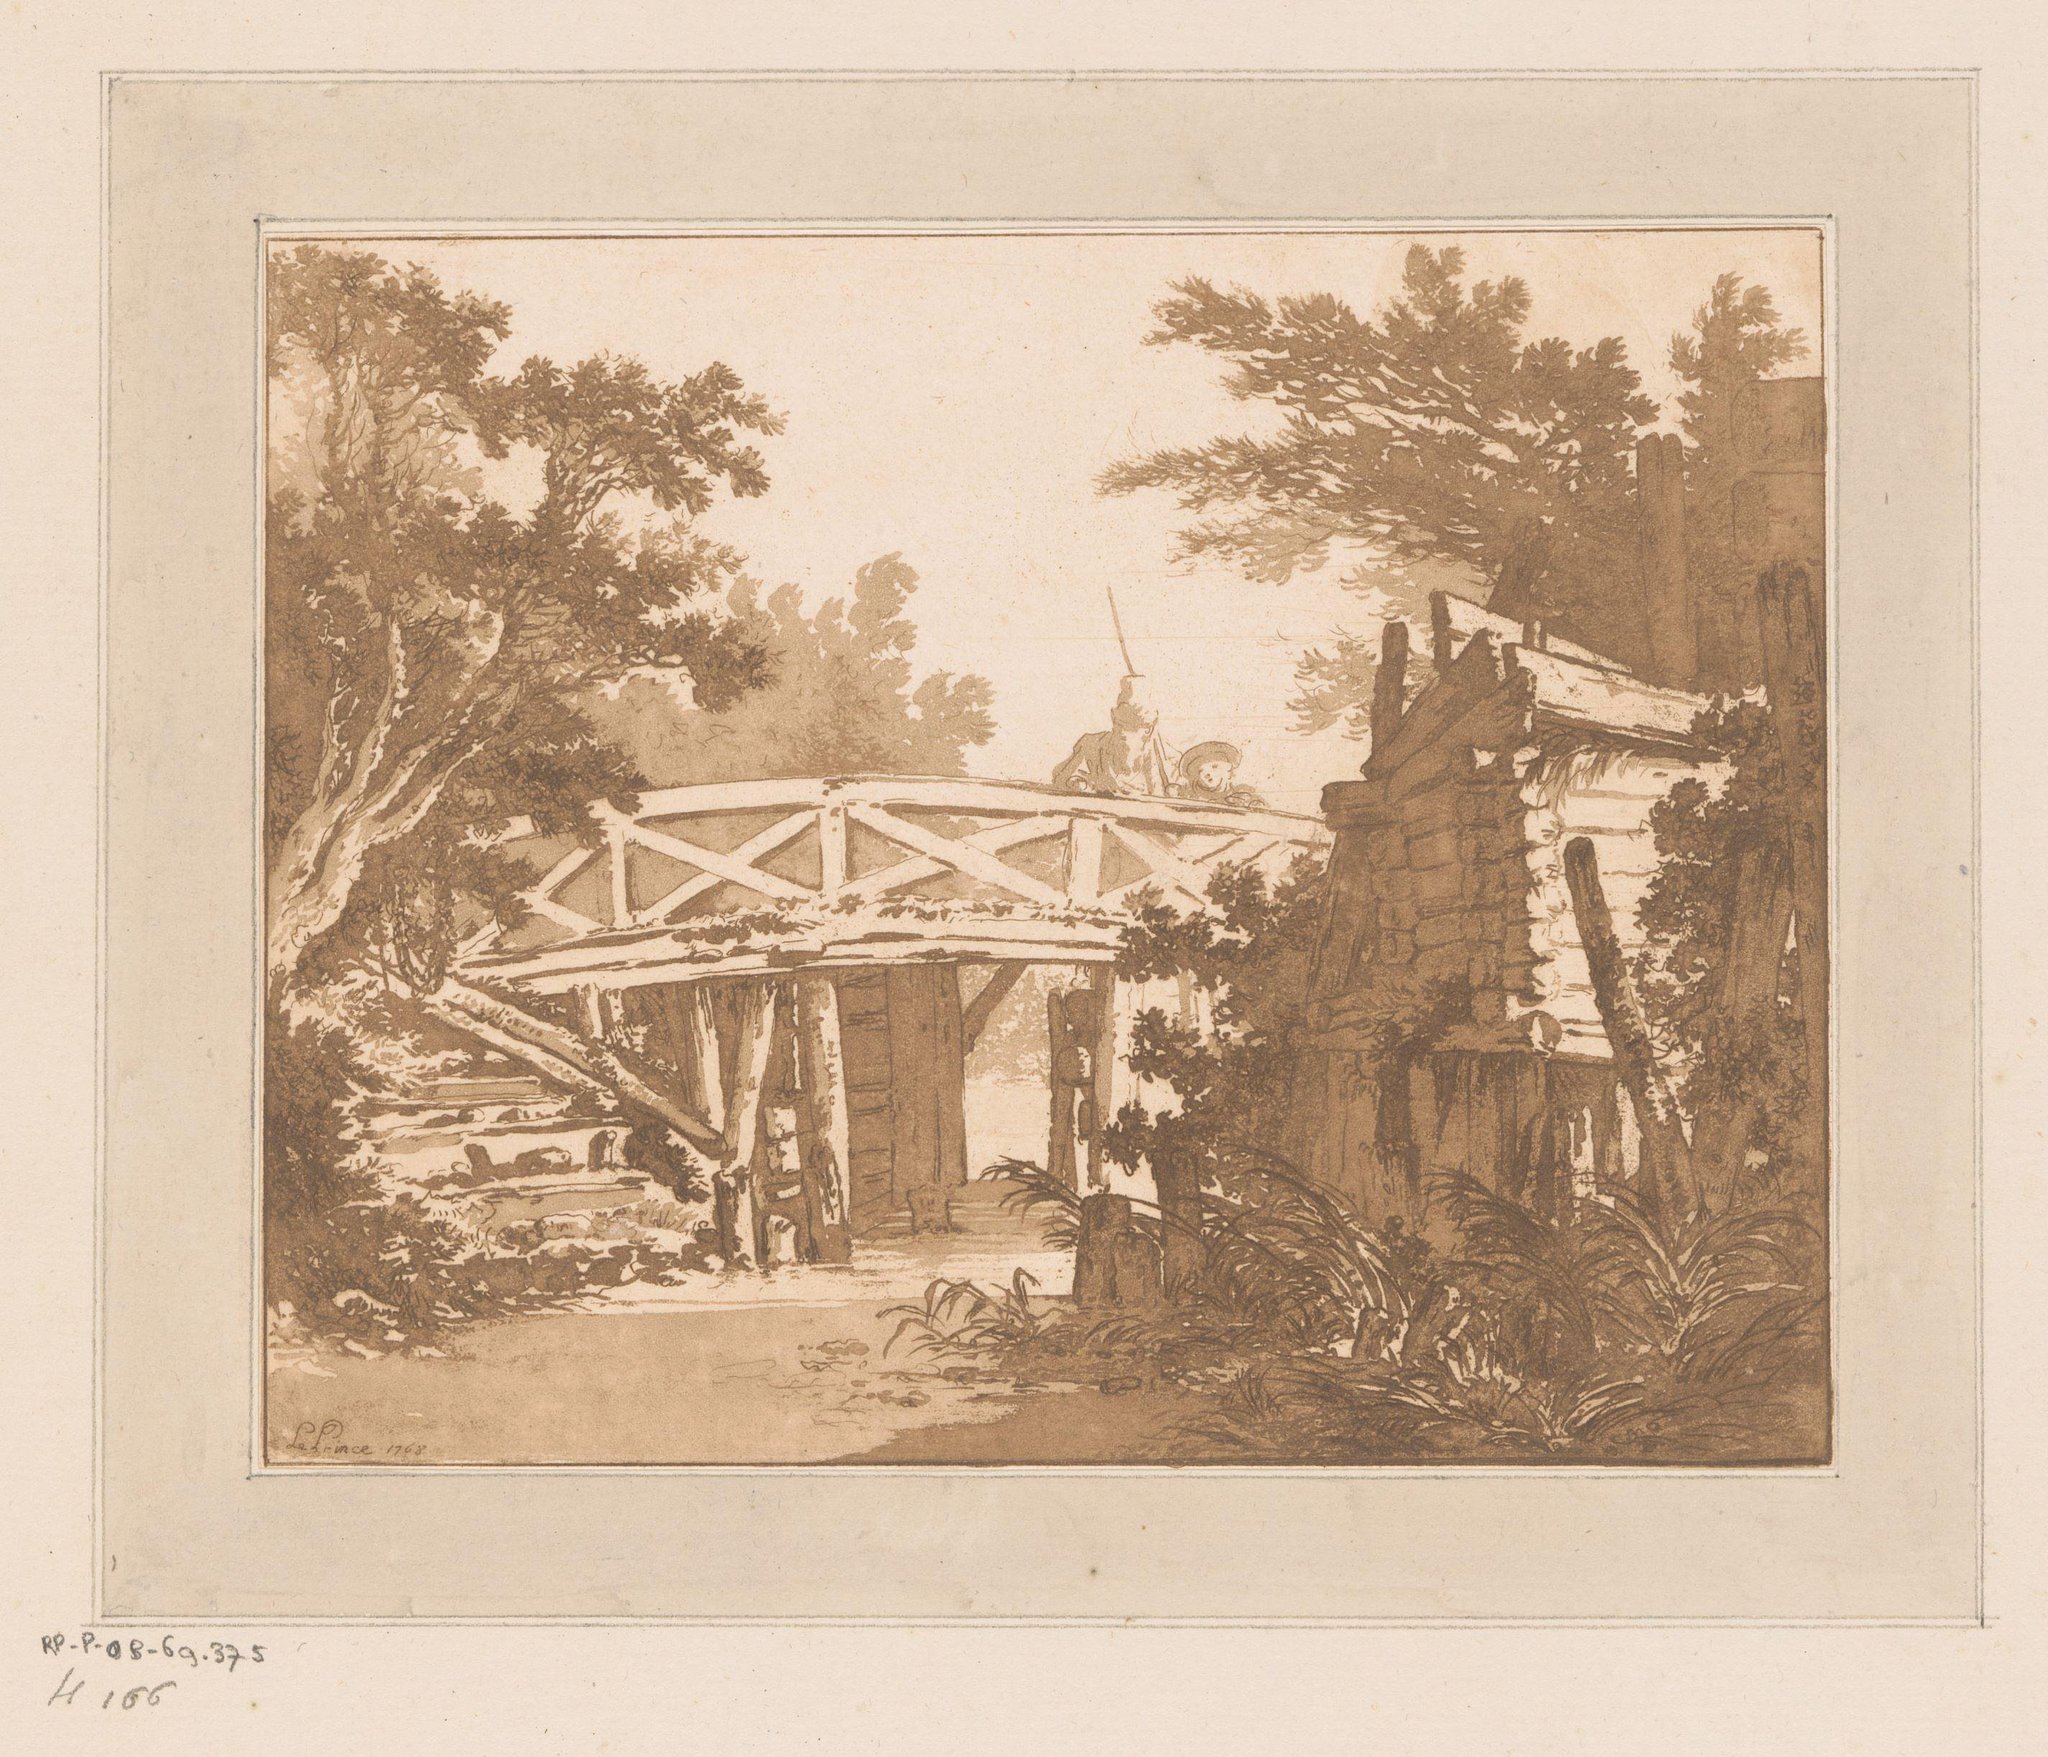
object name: print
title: Man en kind met hengel op een brug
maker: jean baptist leprince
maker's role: draughtsman, print maker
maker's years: 1734-1781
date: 1768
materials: paper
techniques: aquatint, etching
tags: landscape with bridge, viaduct or aqueduct, bridge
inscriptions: date